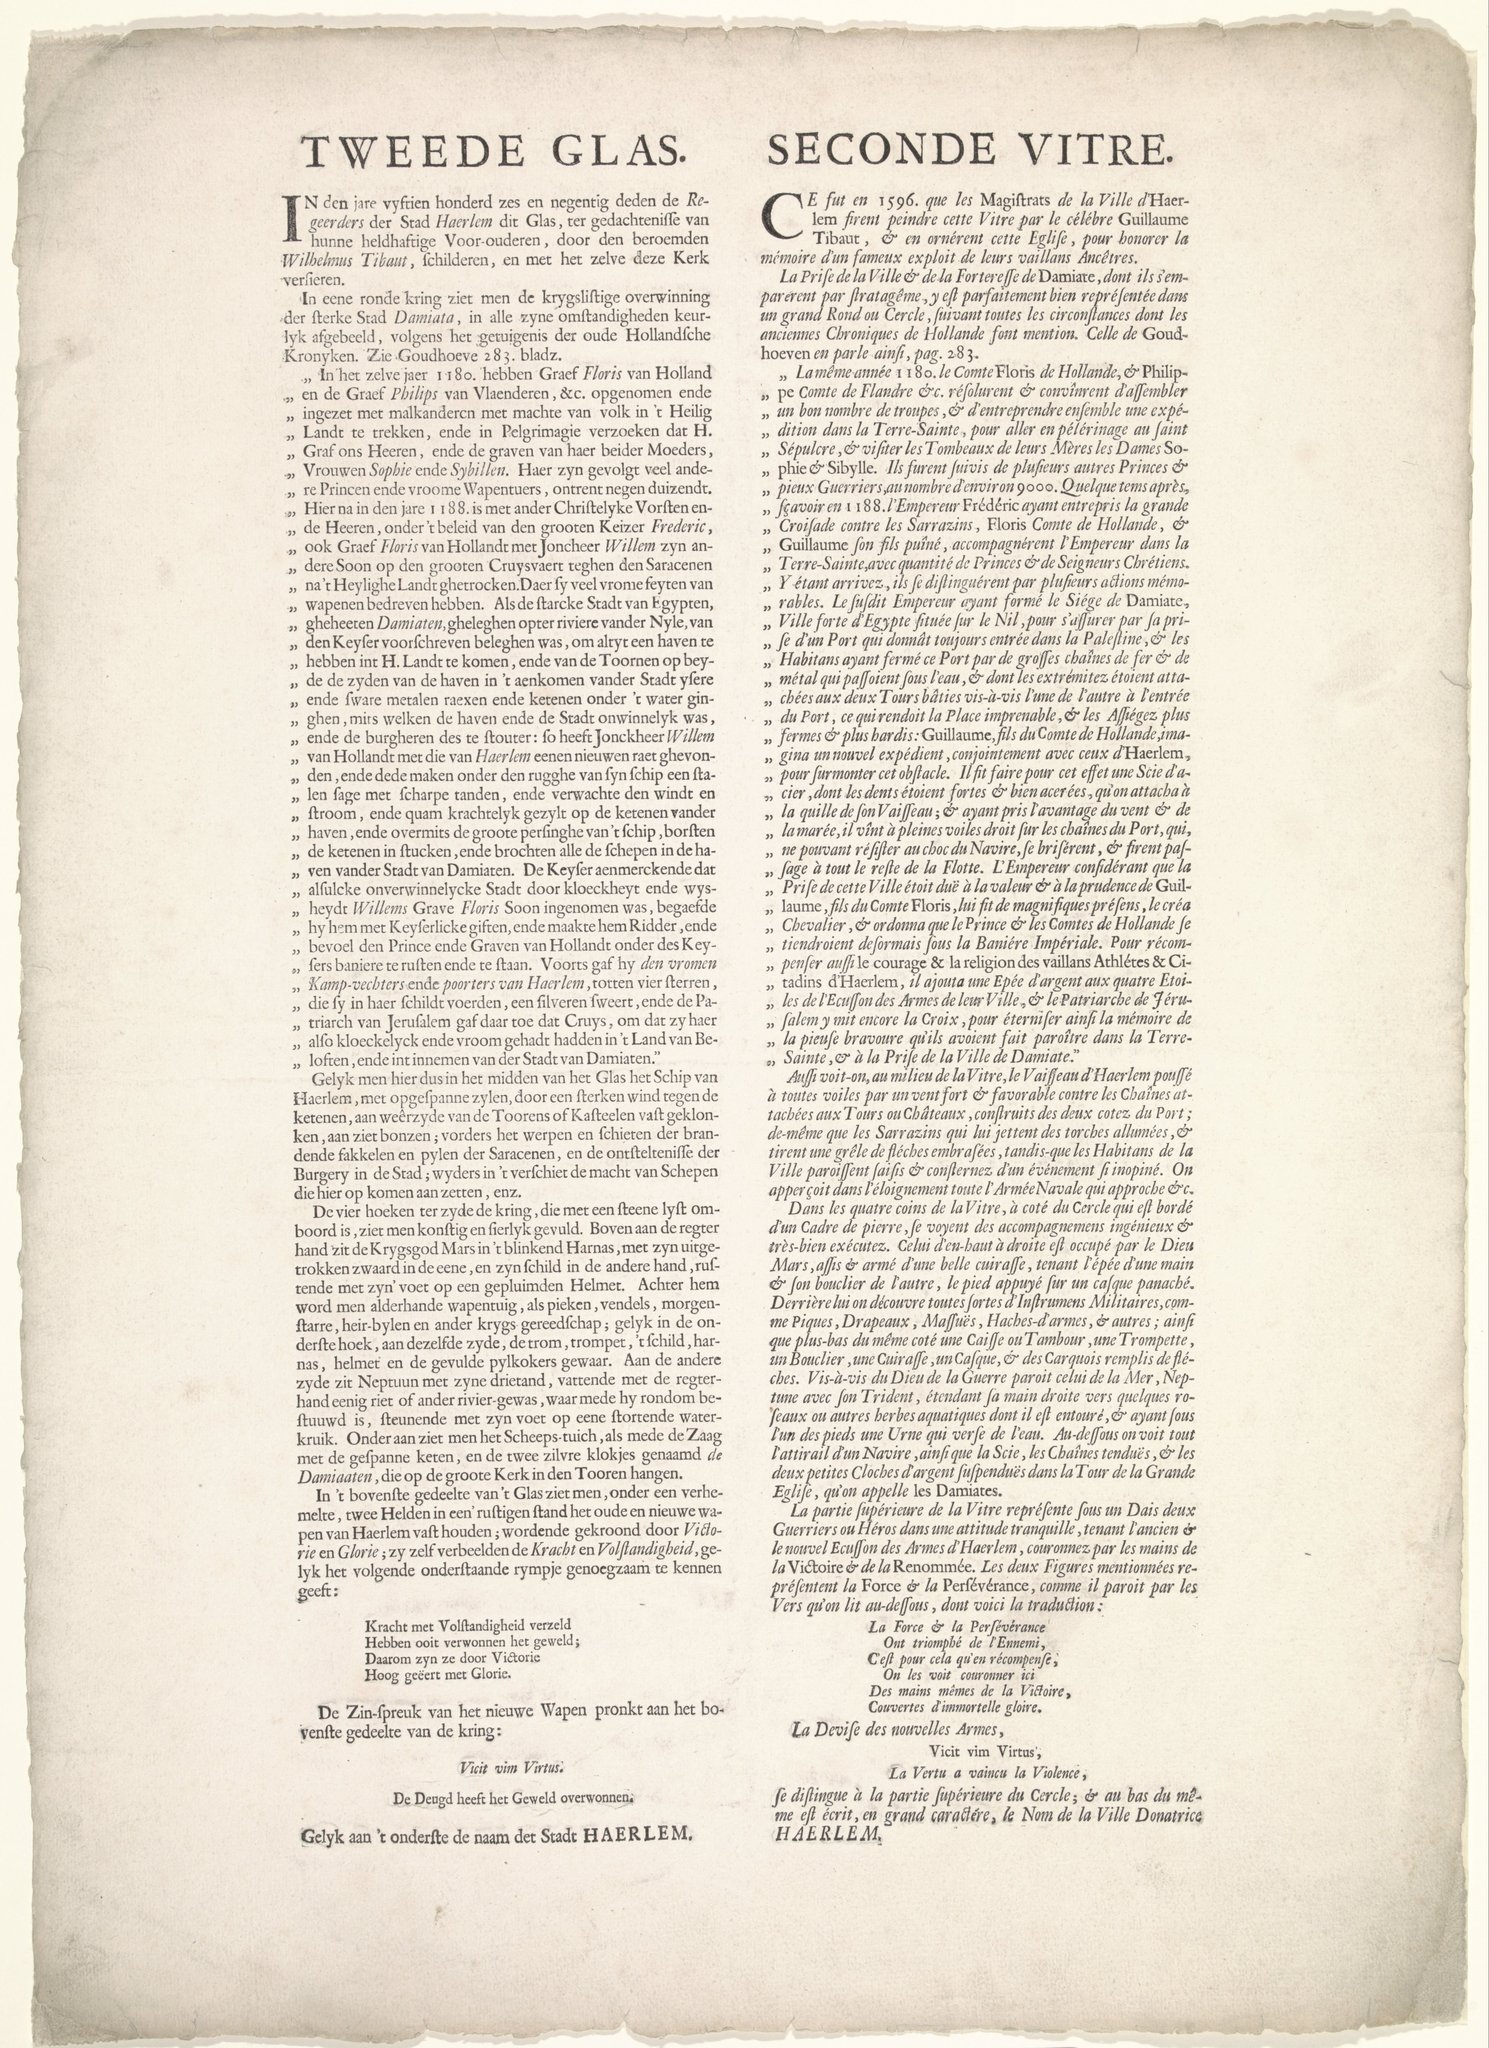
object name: text sheet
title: Tweede glas / Seconde vitre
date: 1738-1754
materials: paper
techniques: letterpress printing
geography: amsterdam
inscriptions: collector's mark: Lugt 2228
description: Toelichting bij het door Pieter Tanjé in prent gebrachte tweede glasraam in de Sint-Janskerk Gouda: Inname van Damiate. Twee kolommen tekst in het Nederlands en Frans.